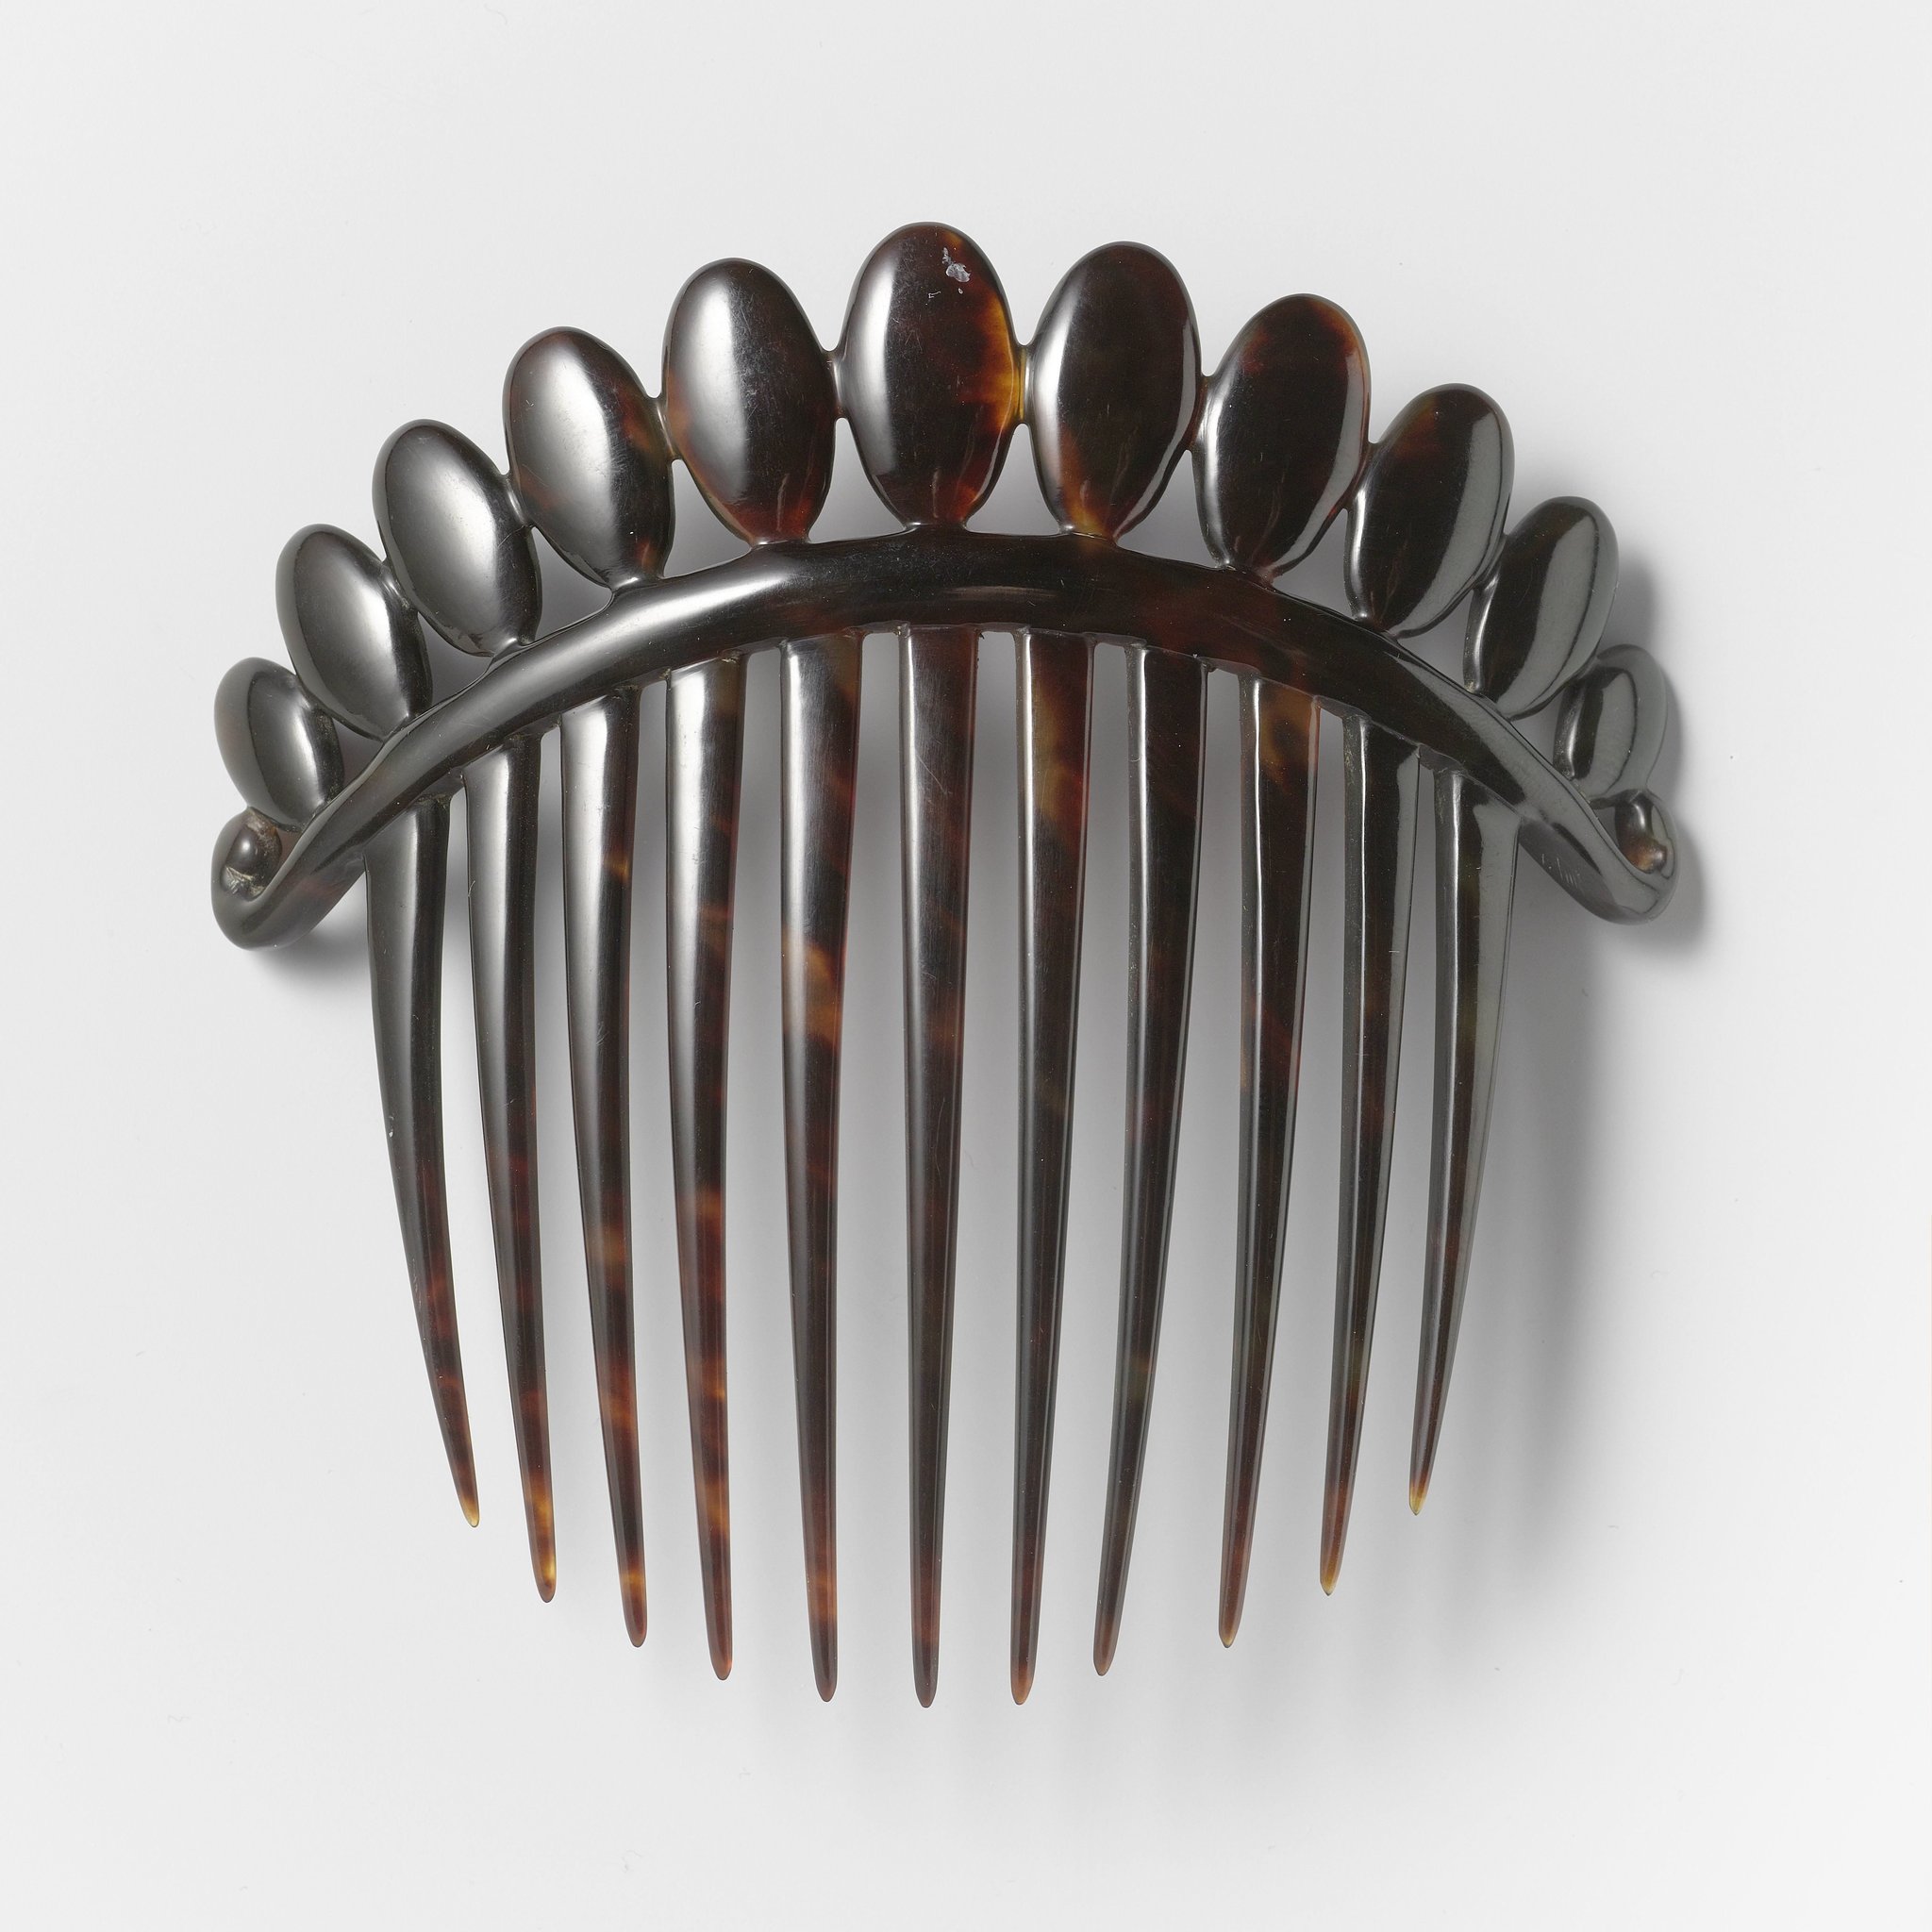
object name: comb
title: Haarkam van imitatie schildpad of hoorn met een rug bestaande uit een aaneenschakeling van ovalen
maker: Anonymous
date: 1875-1899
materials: celluloid, horn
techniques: assembly, filing, polish, pressing, sawing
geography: netherlands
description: Haarkam van imitatie schildpad of hoorn met een rug bestaande uit een aaneenschakeling van ovalen, die naar het midden toe groter worden. Elf tanden, die naar het midden toe langer worden.